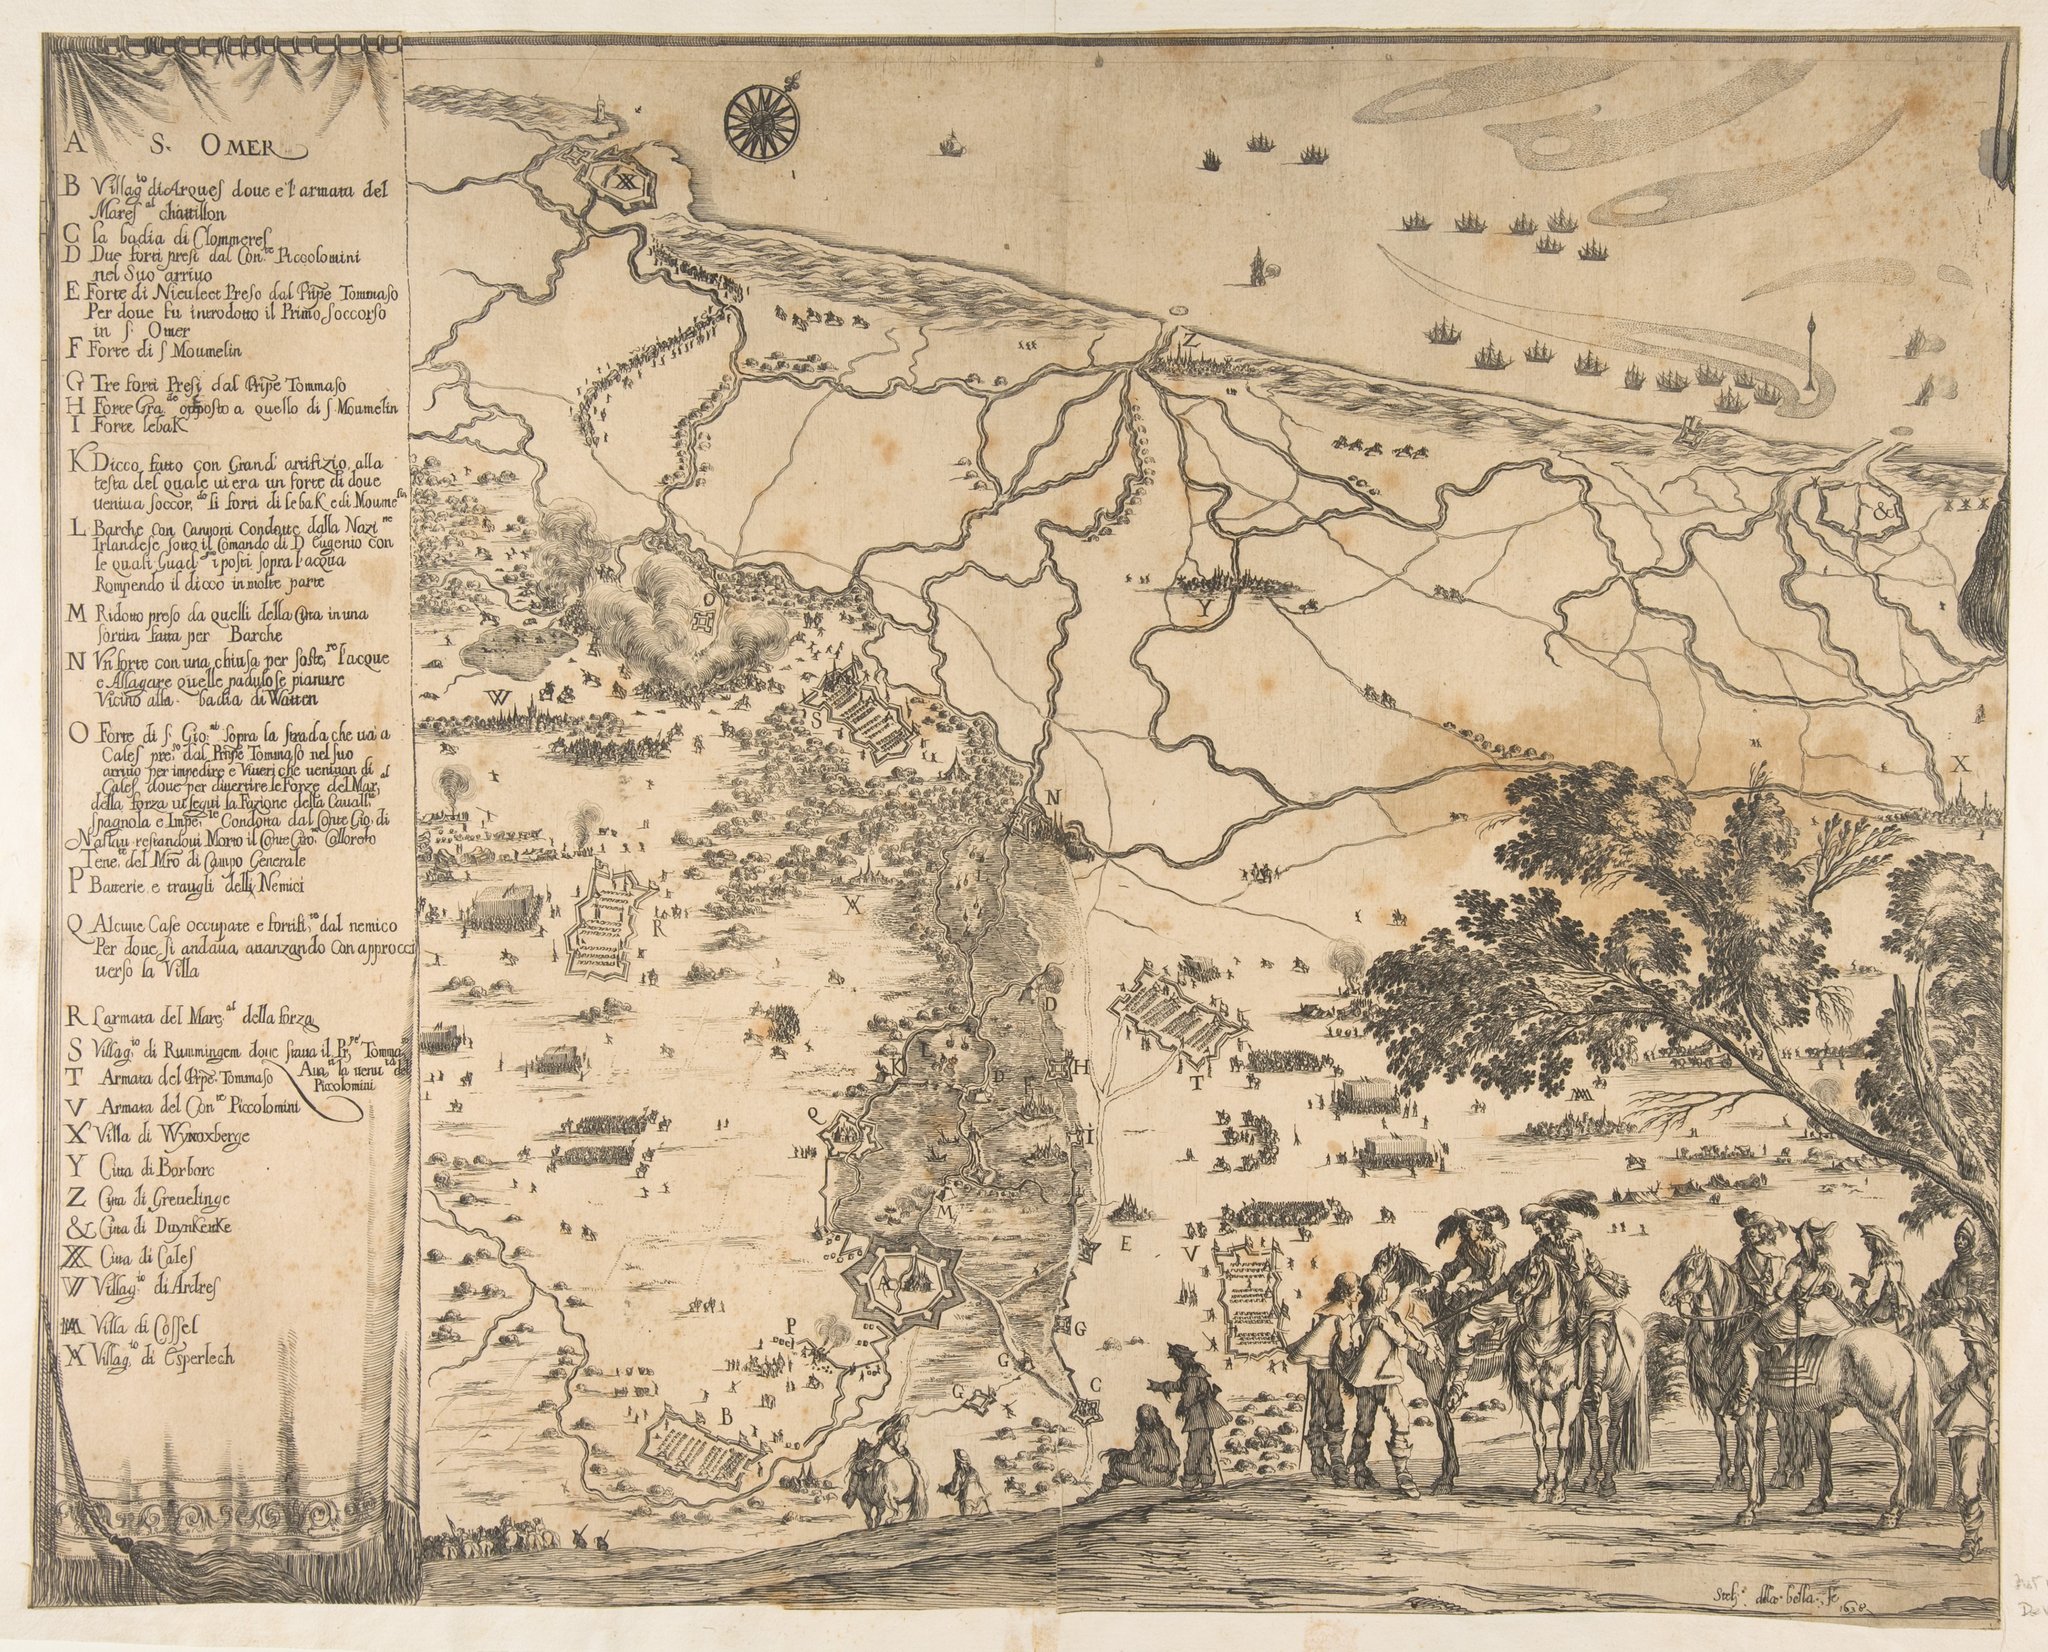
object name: print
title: Siege of Saint-Omer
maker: stefano della bella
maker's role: artist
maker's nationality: italian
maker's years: 1610-1664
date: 1638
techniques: etching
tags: human figures,horses,maps